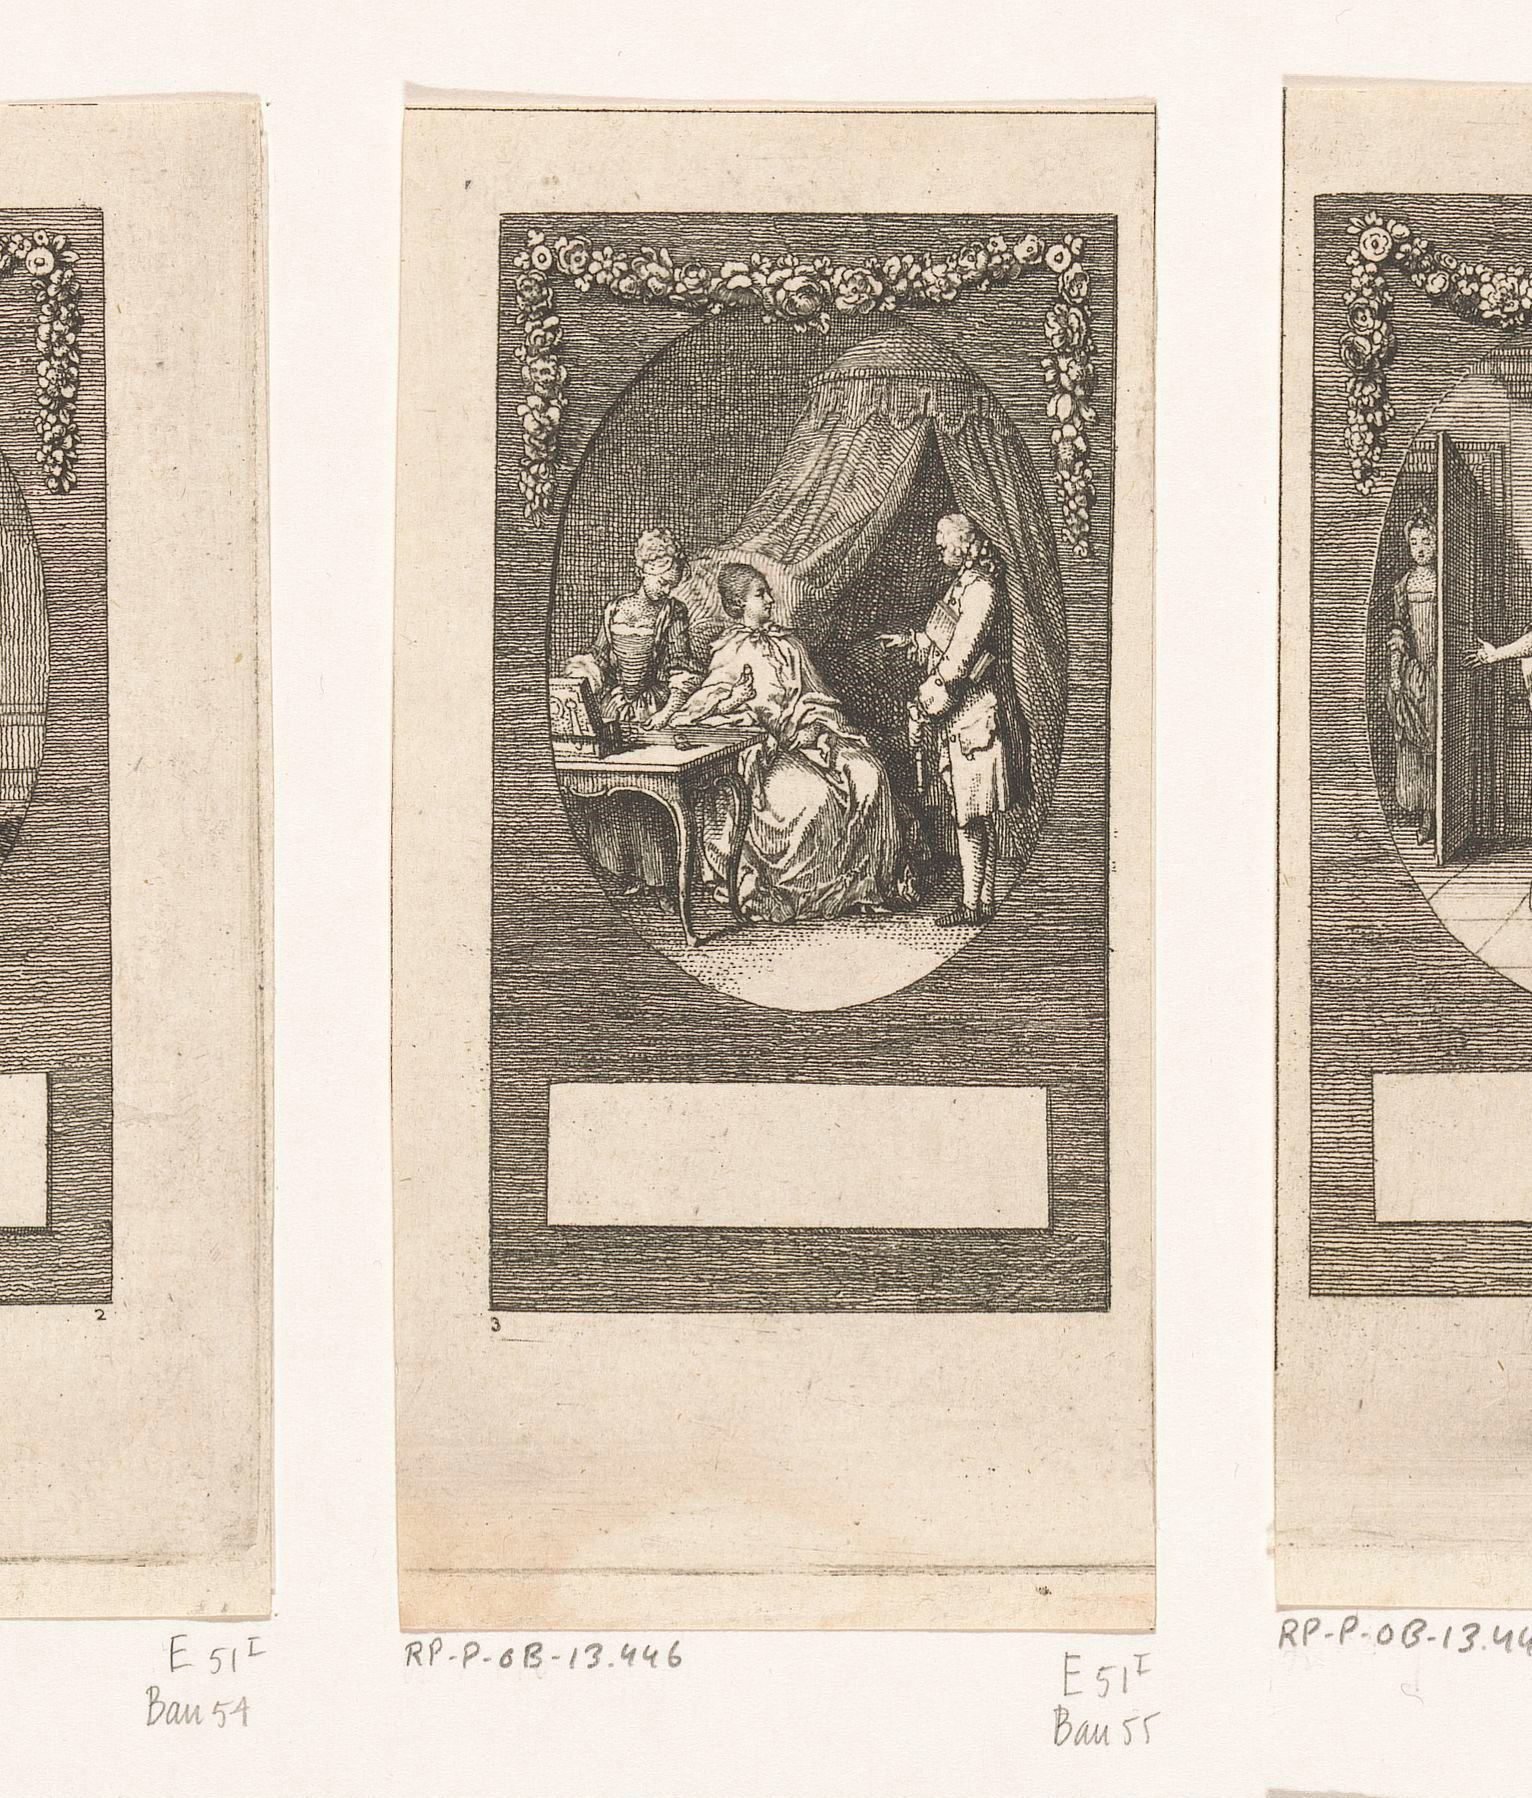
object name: print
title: De waard luistert naar Franziska en Minna von Barnhelm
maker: daniel nikolaus chodowiecki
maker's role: draughtsman, print maker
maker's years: 1726-1801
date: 1769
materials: paper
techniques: etching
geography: berlin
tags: literary characters and objects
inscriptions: collector's mark: Lugt 2228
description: Deze prent maakt onderdeel uit van een serie van twaalf scènes die het toneelstuk 'Minna von Barnhelm' van Gotthold Ephraim Lessing illustreren (eerste uitvoering 1767). Chodowiecki bracht het toneelstuk twee keer in prent, een met onderschriften in het Frans en een met onderschriften in het Duits. Bij beide series werden de scènes op een plaat geëtst. Deze prent hoort bij de Franse serie, gebruikt als boekillustratie in: 'Almanac Genealogique pour l'an 1770'.